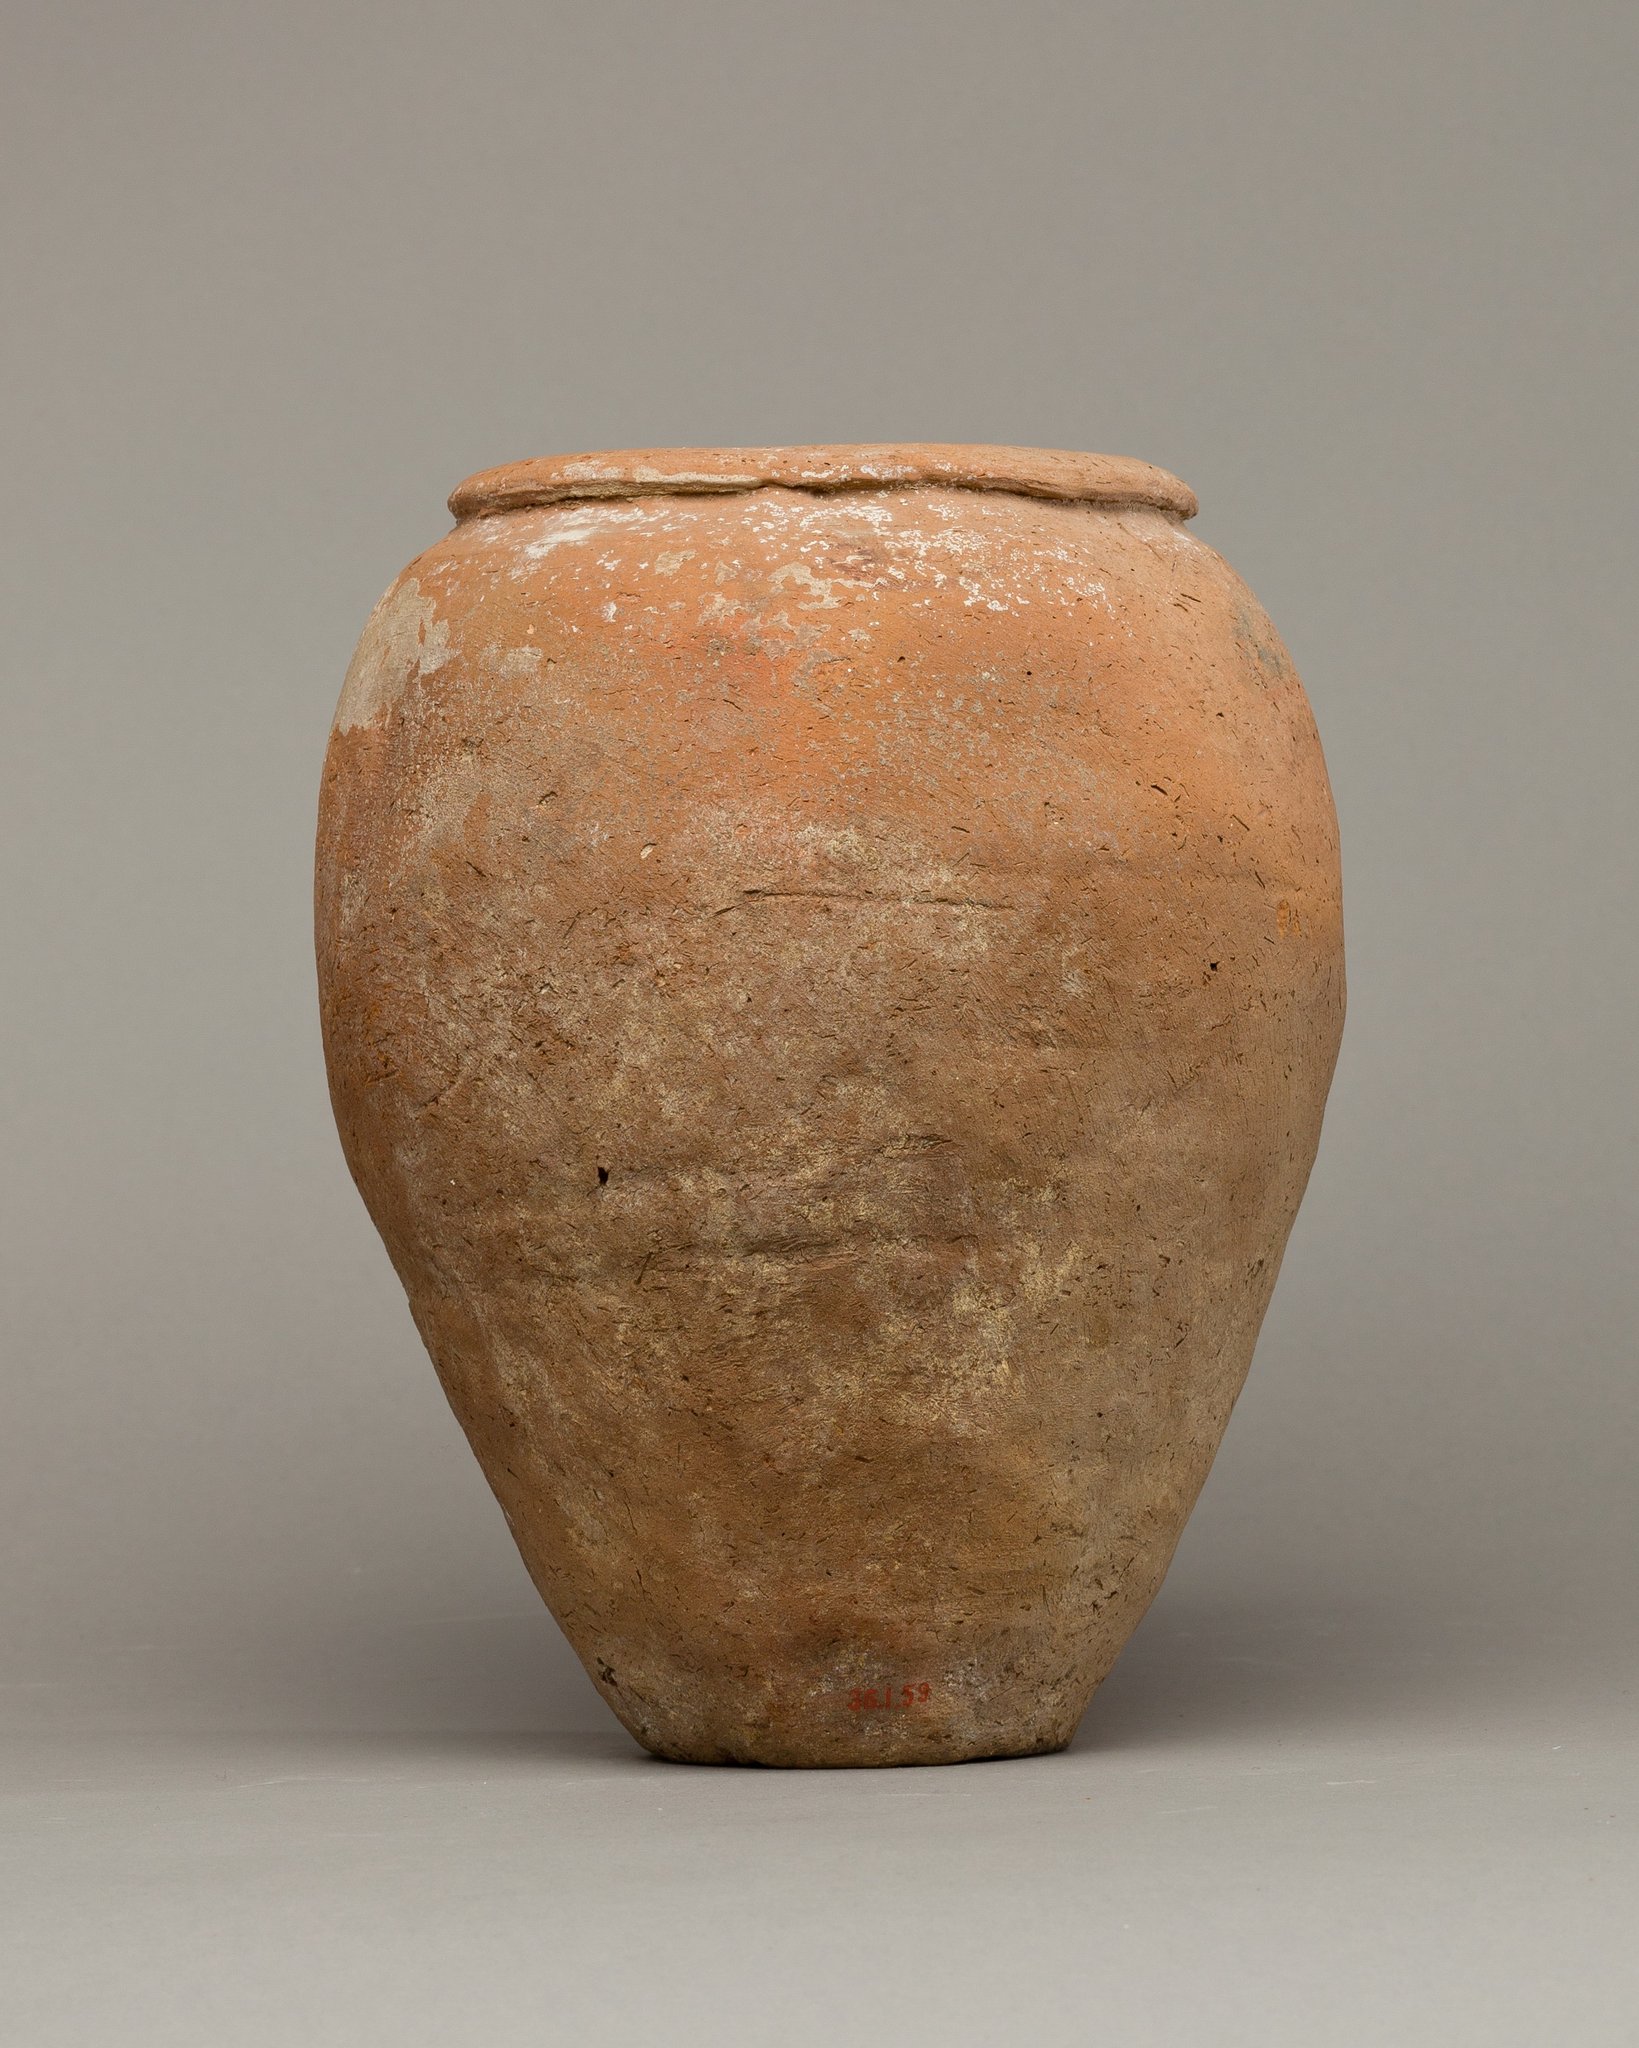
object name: jar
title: Large shouldered jar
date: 3850-2960 BCE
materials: pottery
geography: egypt